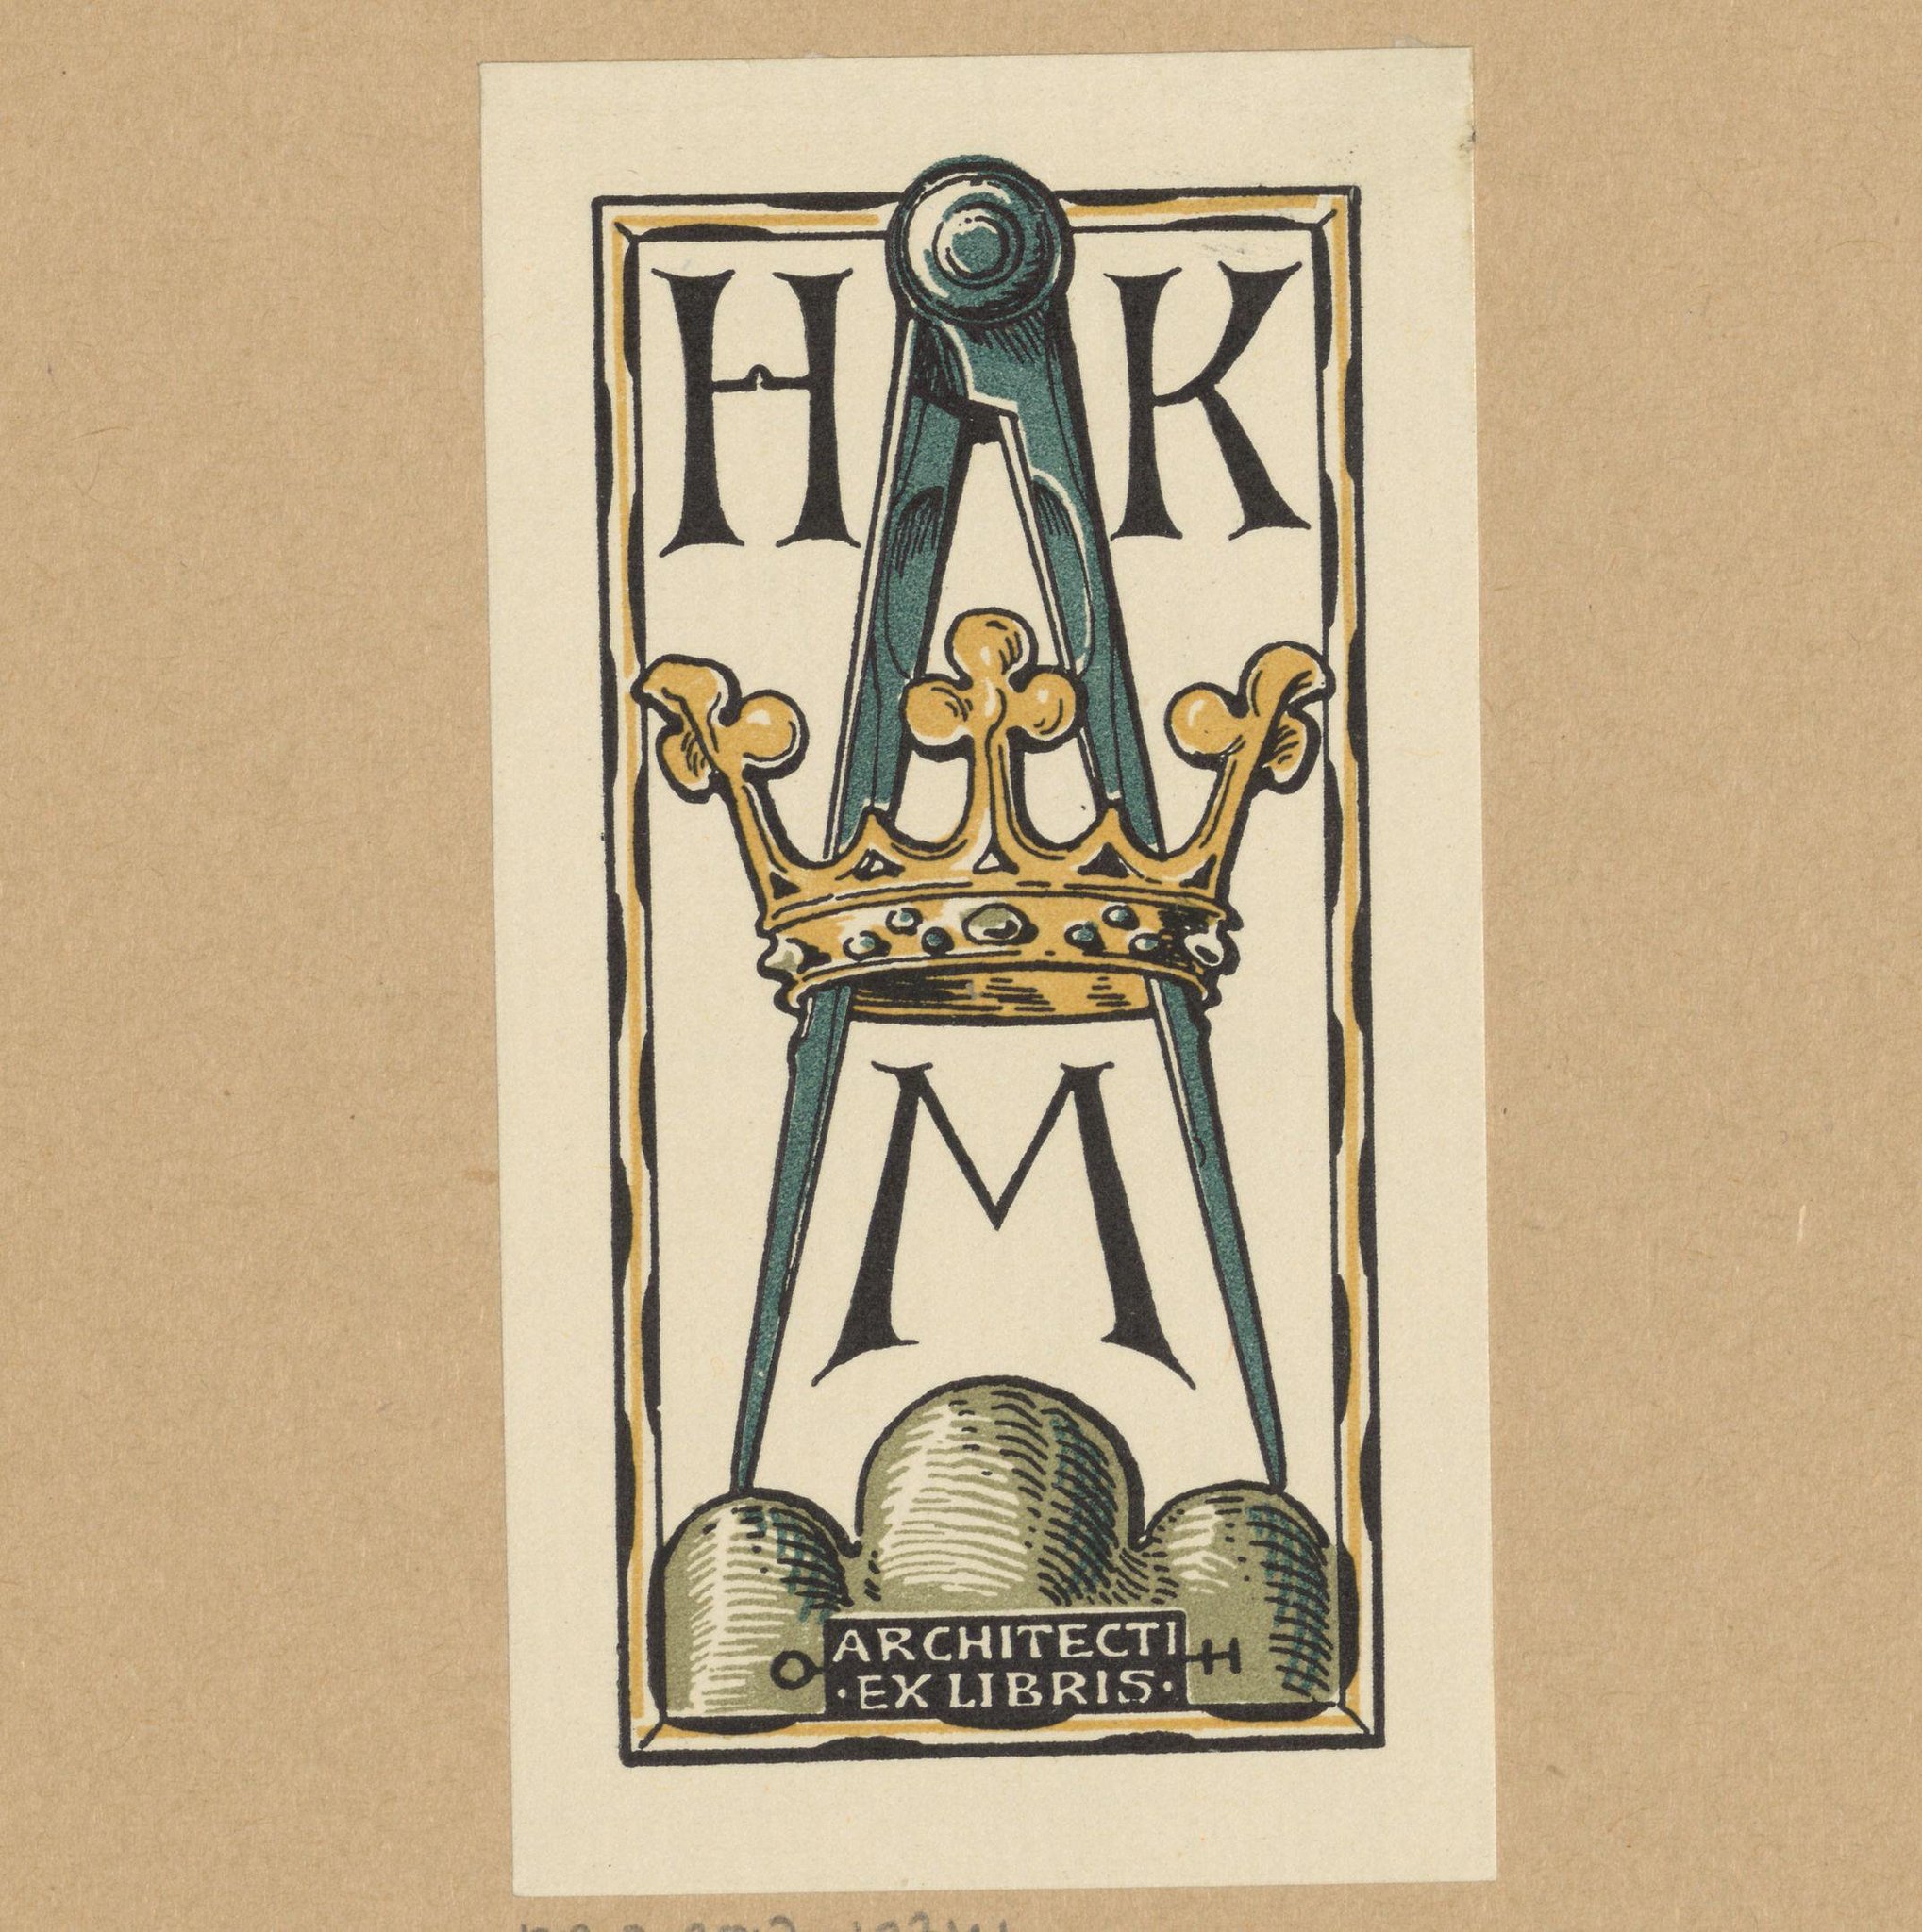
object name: bookplate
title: Ex libris van H.K.M. architecten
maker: otto hupp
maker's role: print maker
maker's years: 1859-1949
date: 1880-1949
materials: paper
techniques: lithograph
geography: germany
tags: crown (symbol of sovereignty), compasses